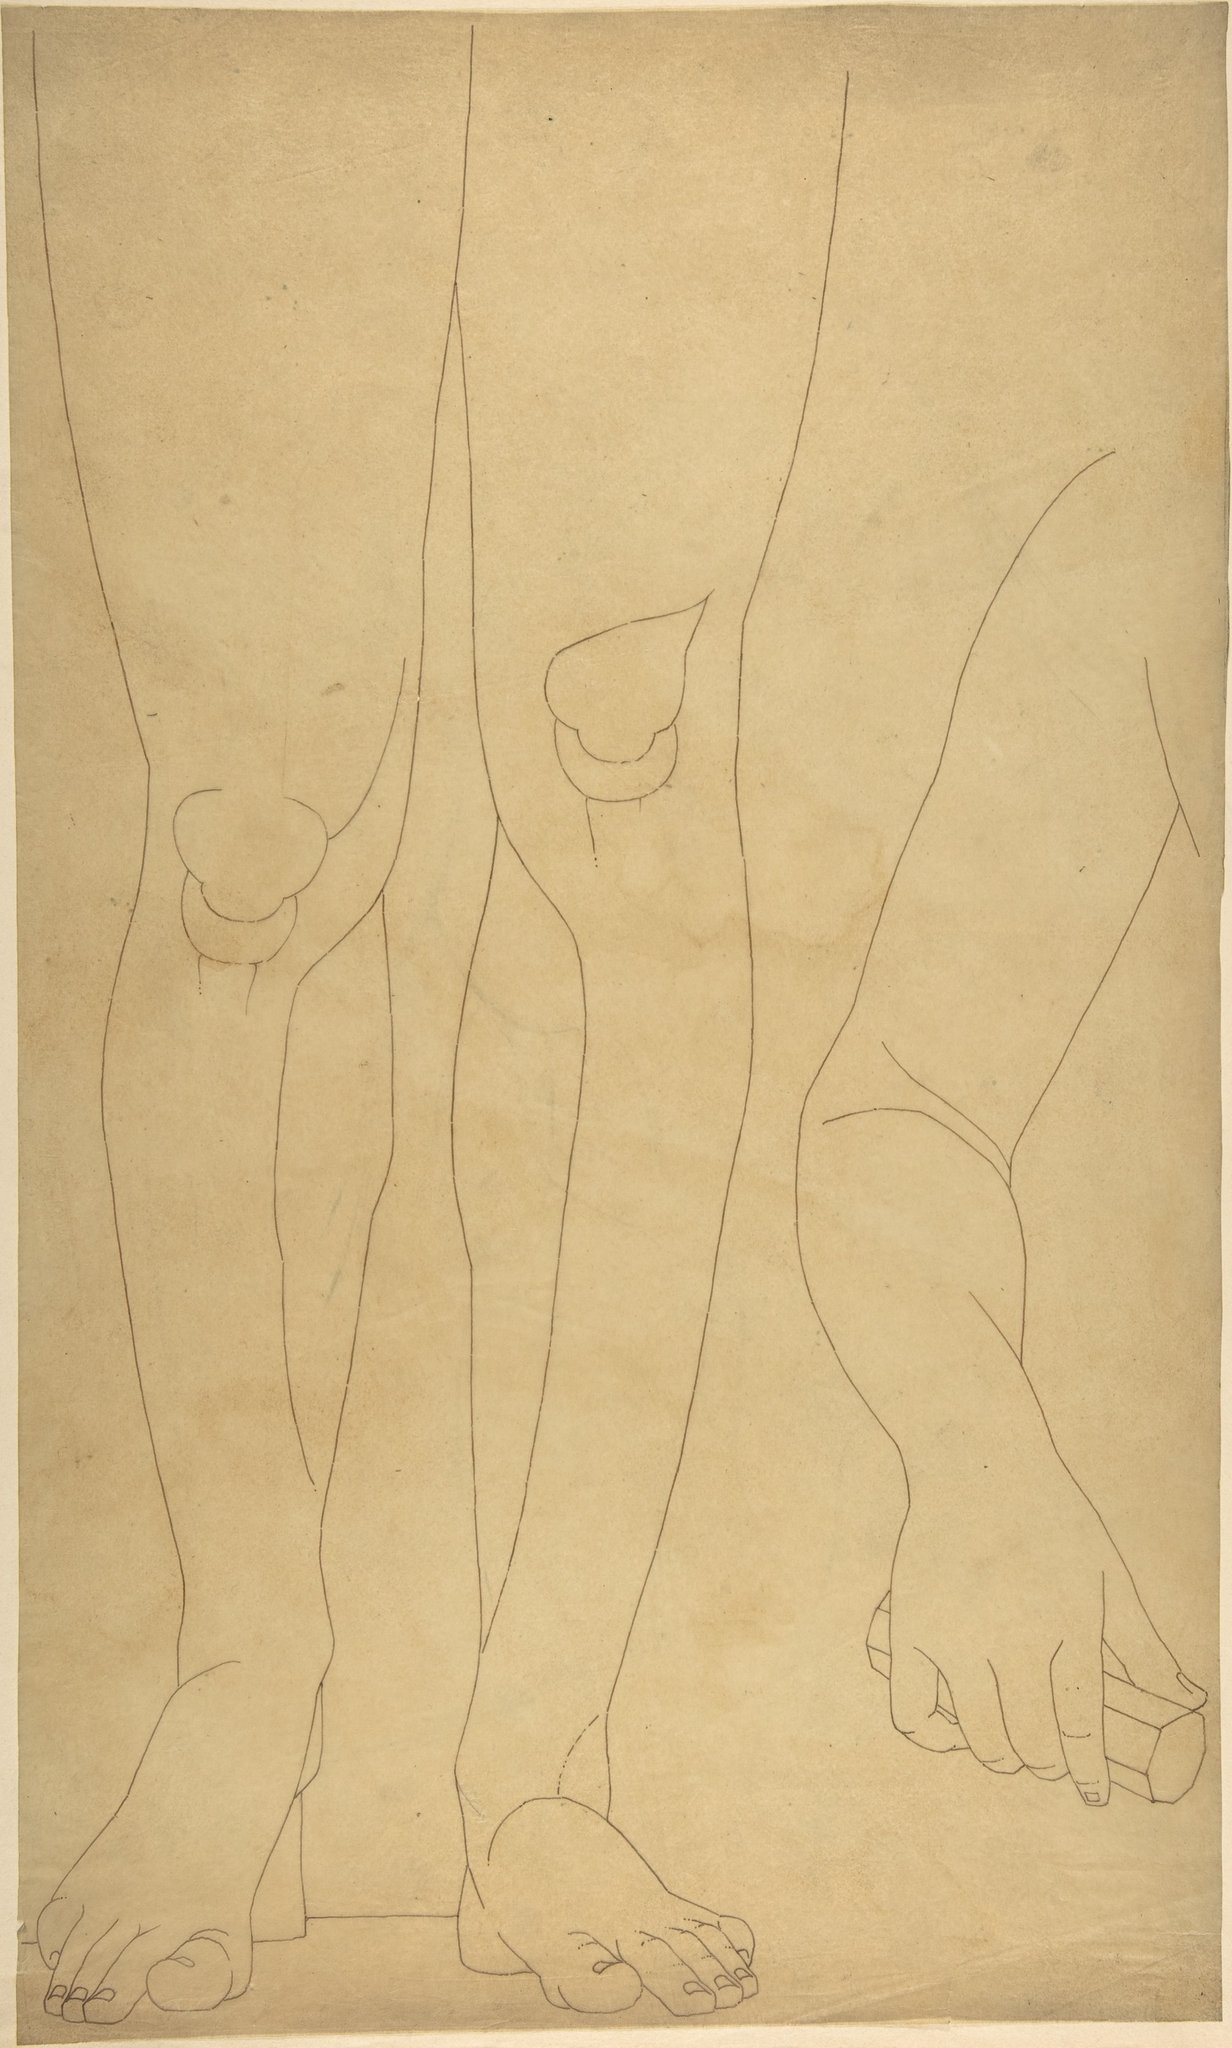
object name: drawing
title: Study of Lower Legs and an Arm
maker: william pitts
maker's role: artist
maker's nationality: british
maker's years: 1790-1840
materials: ink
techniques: pen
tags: feet,hands